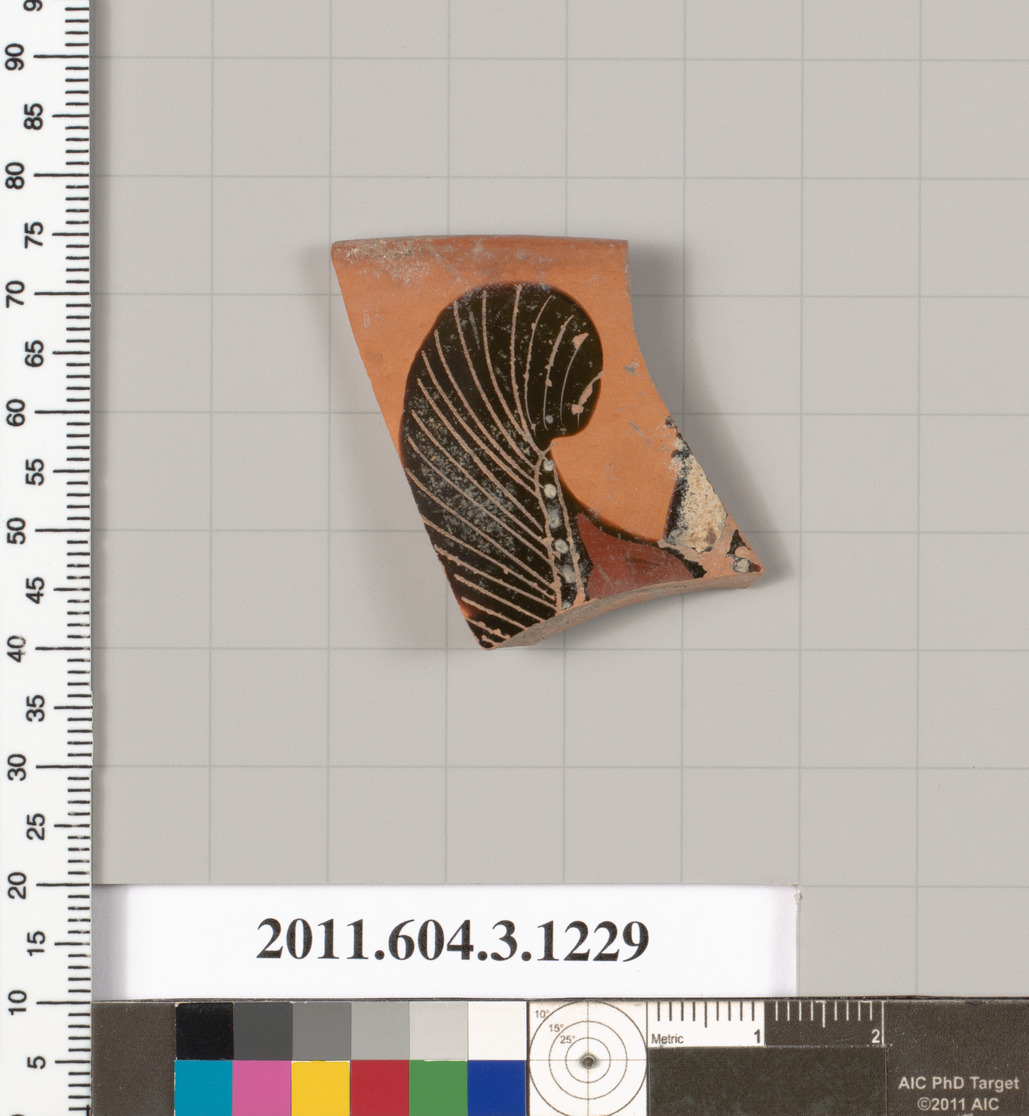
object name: kyathos fragment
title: Terracotta rim fragment of a kyathos (cup-shaped ladle)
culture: greek, attic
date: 534-468 BCE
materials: terracotta